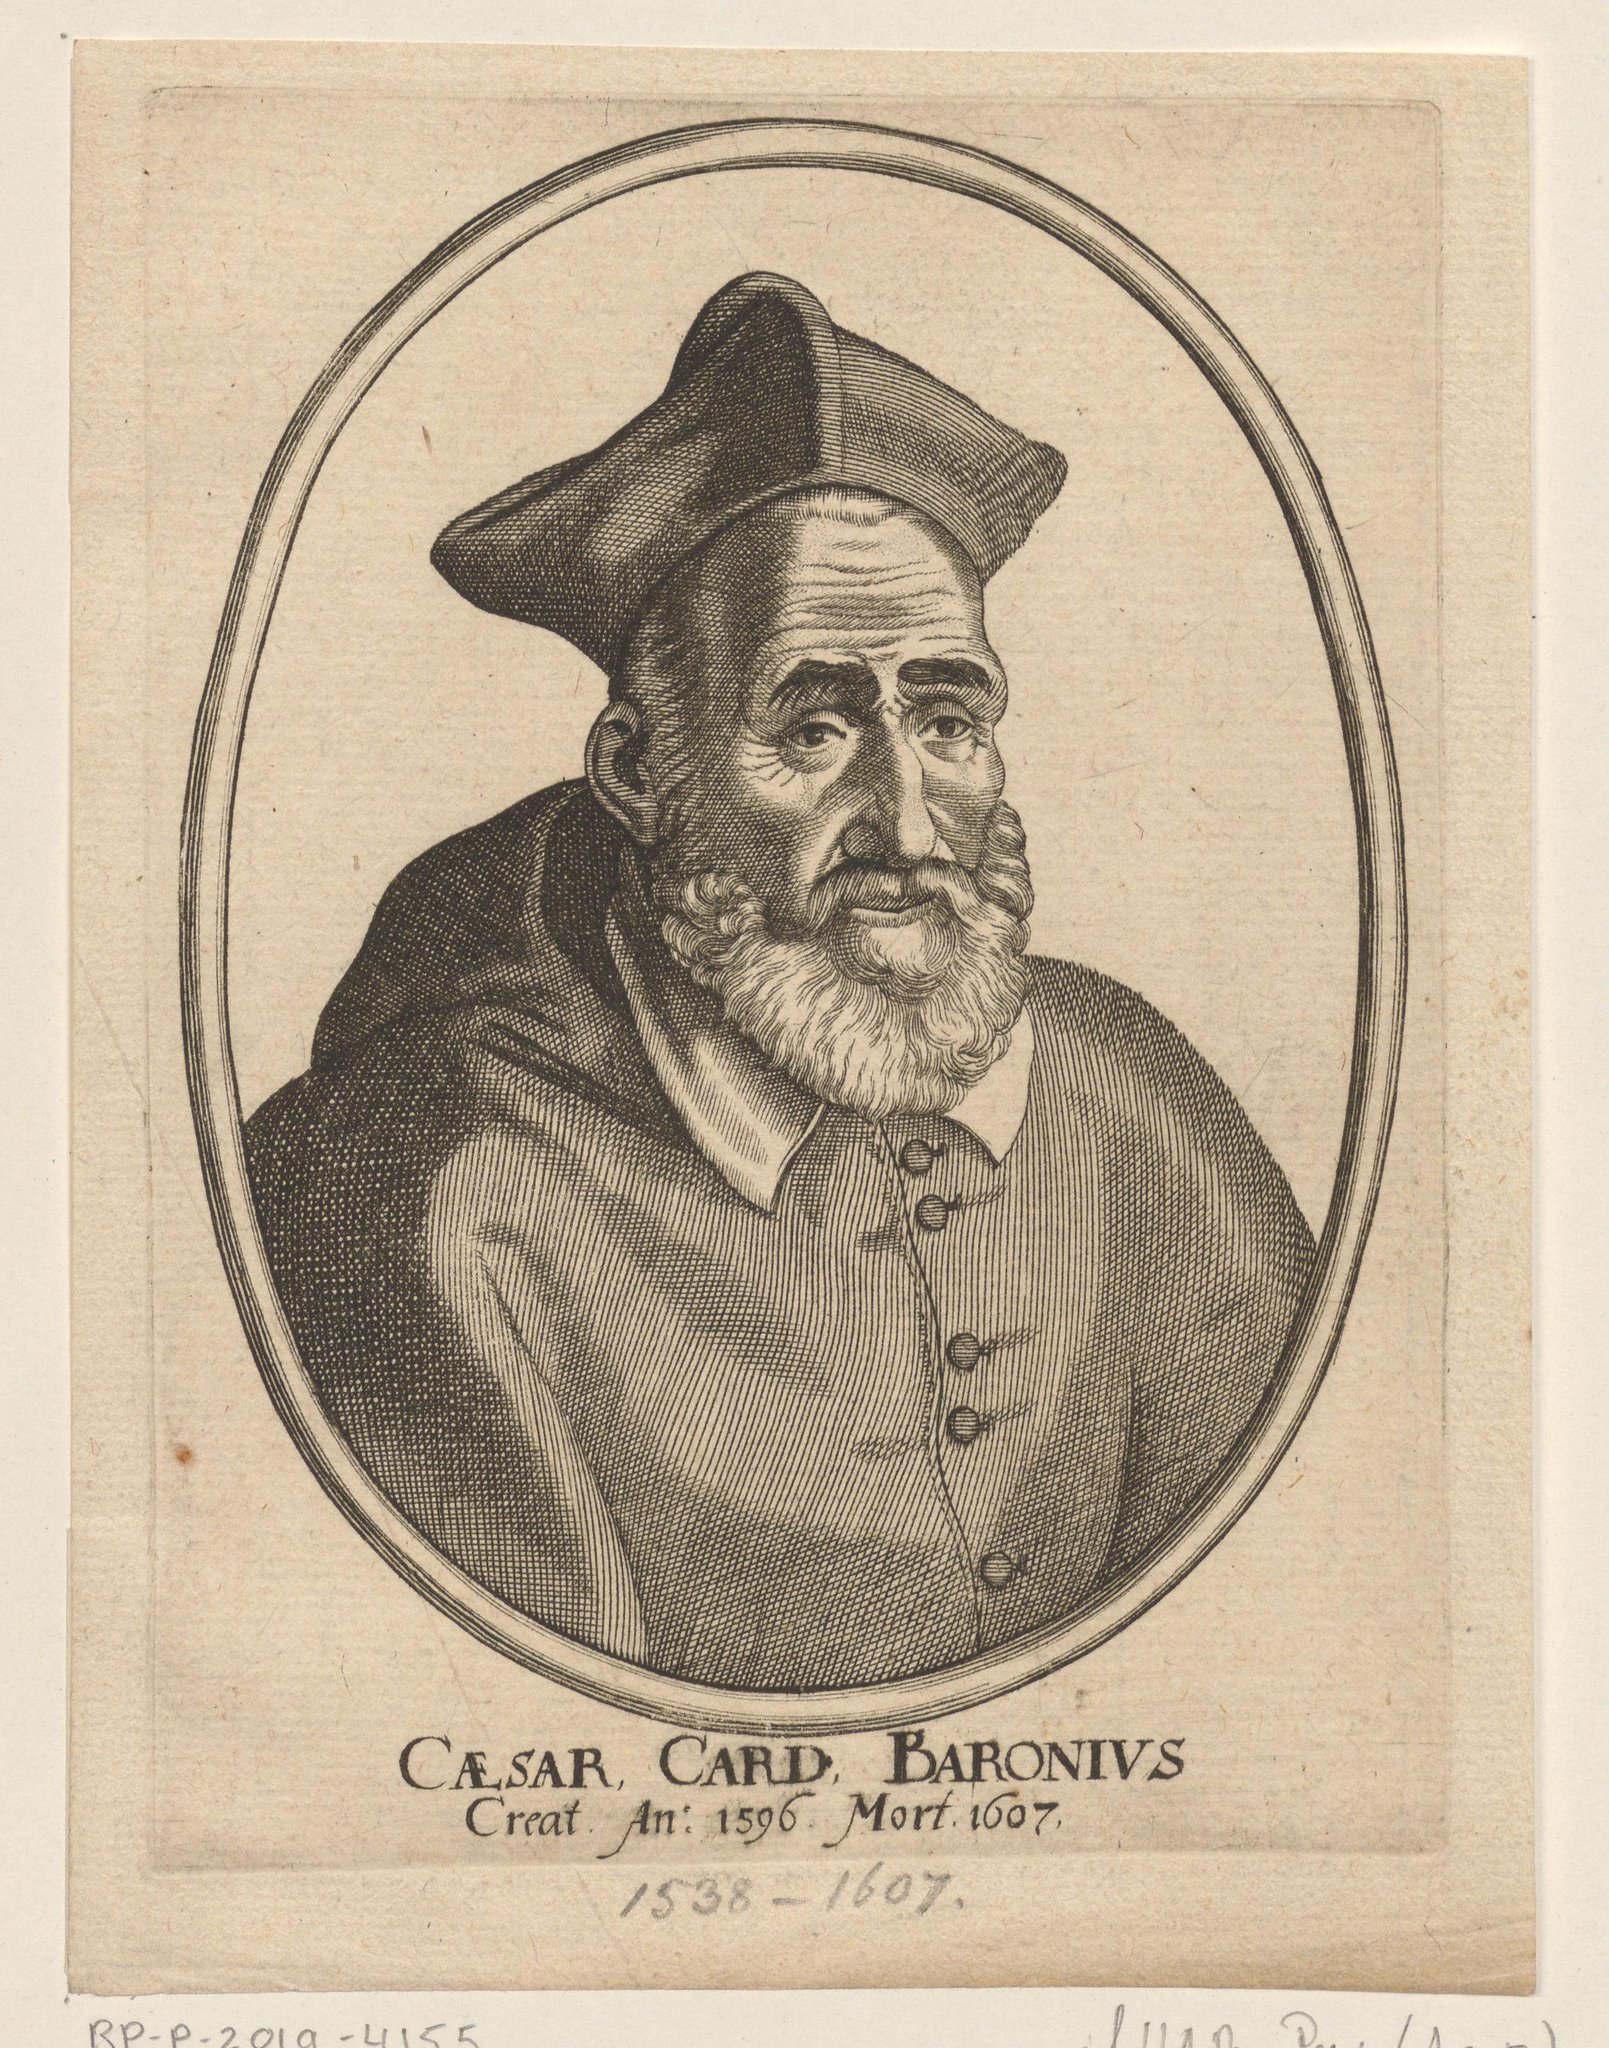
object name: print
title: Portret van kardinaal Cesare Baronio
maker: Anonymous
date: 1607-1649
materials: paper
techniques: engraving, etching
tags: rome, historical persons